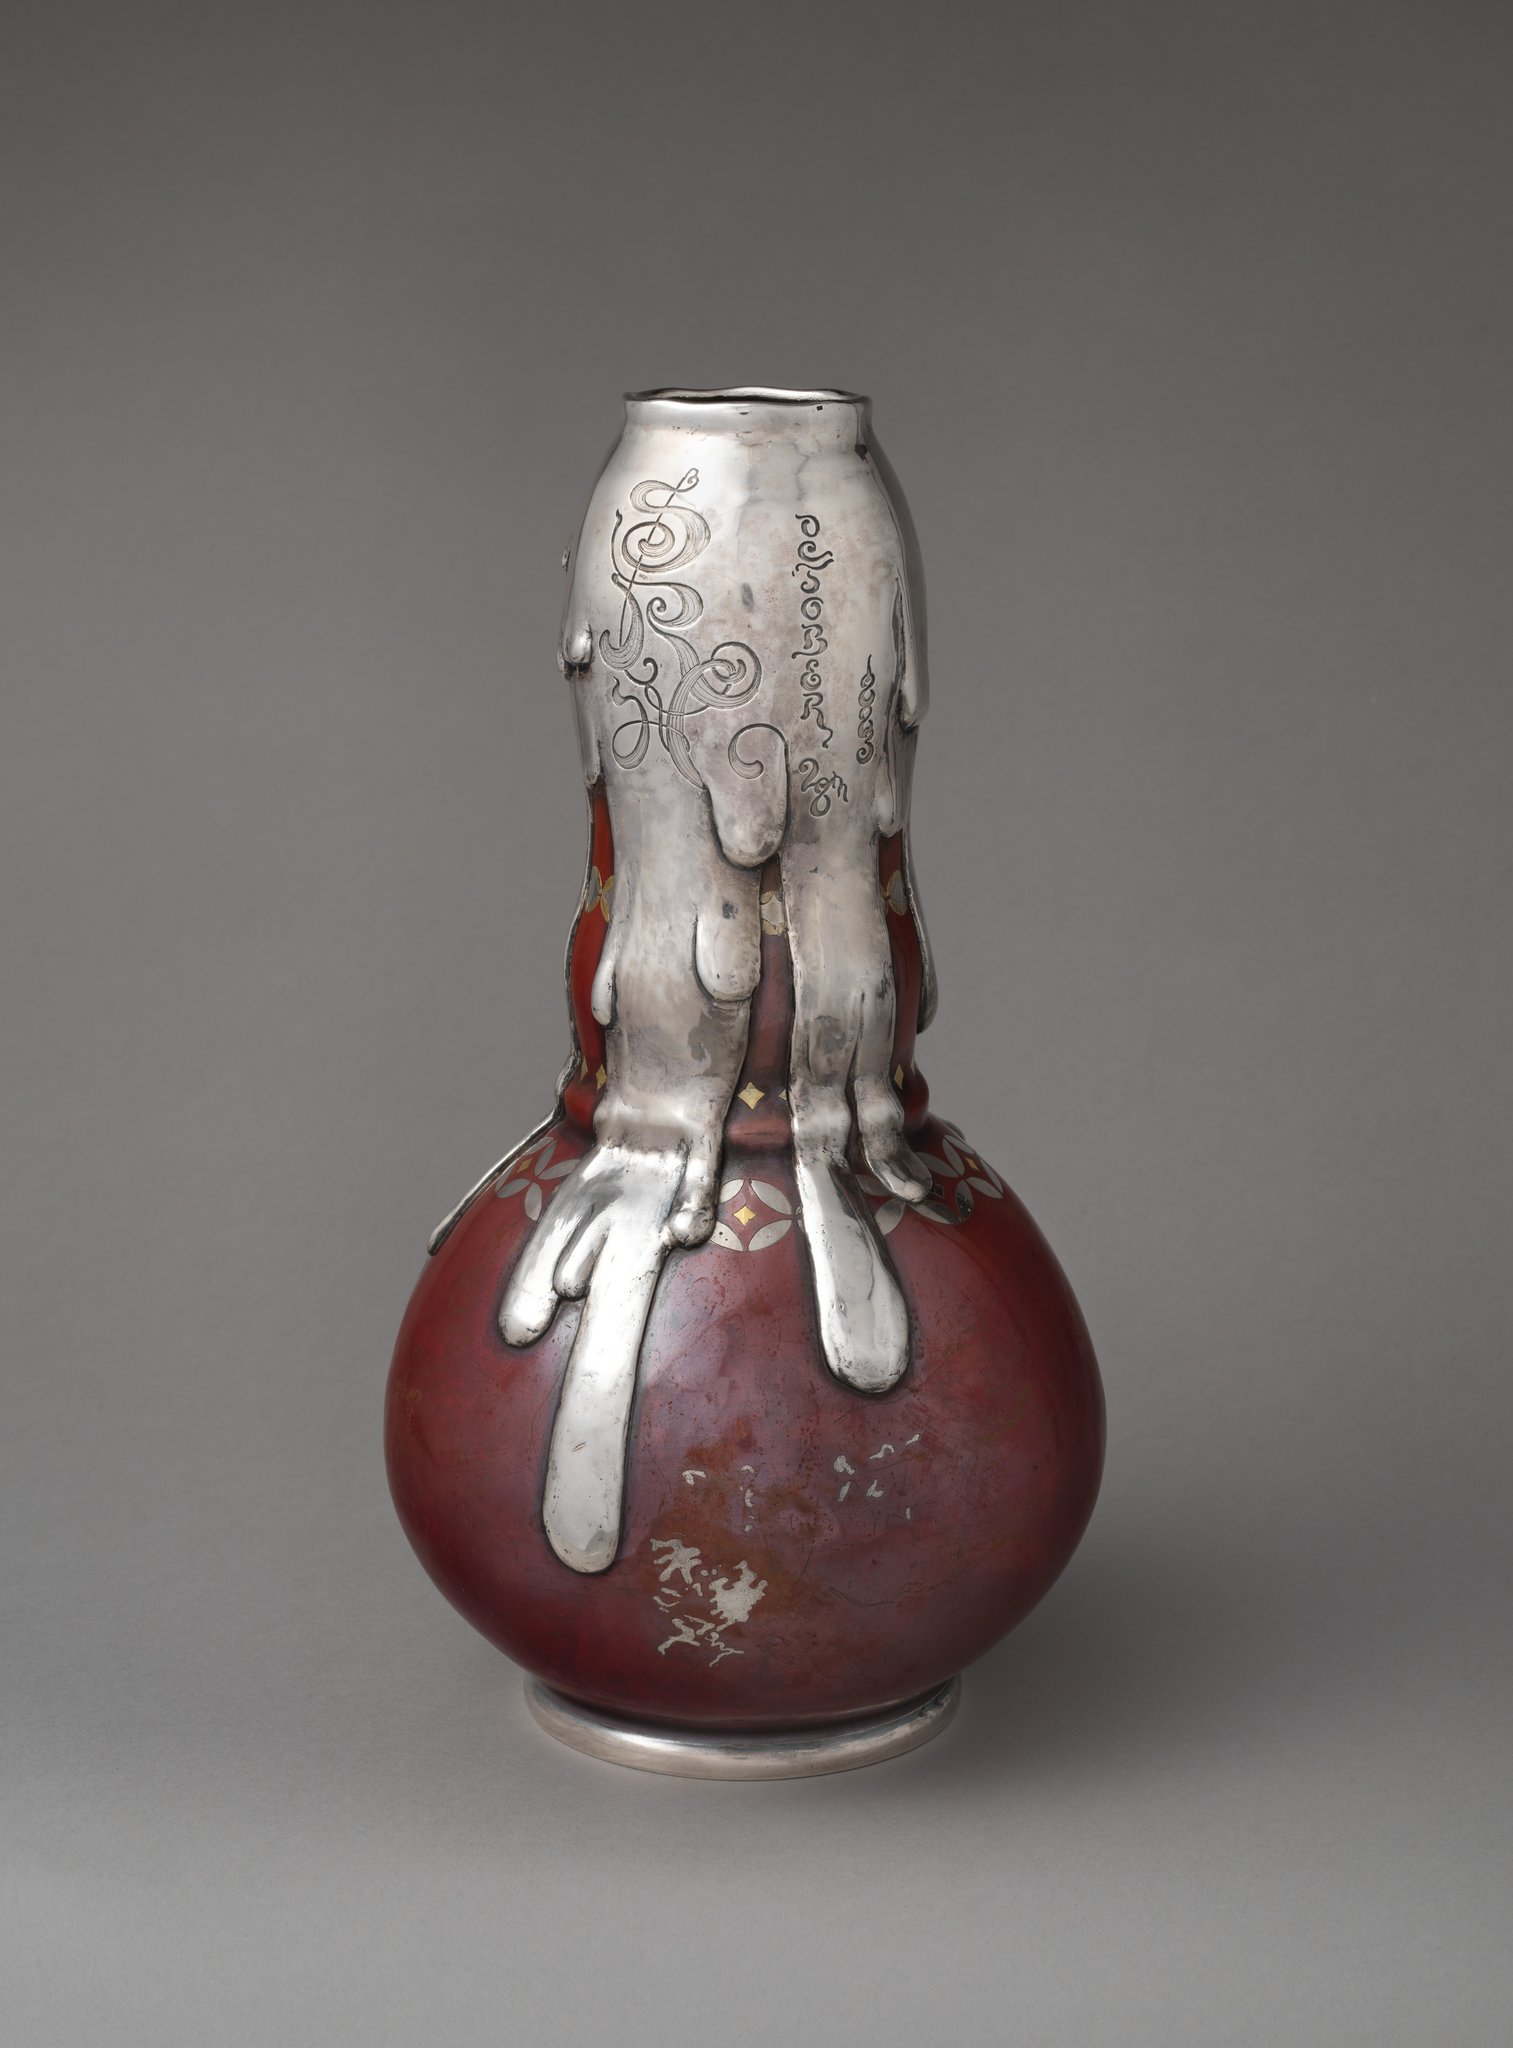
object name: vase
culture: american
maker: tiffany & co.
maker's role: maker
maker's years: 1837-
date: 1879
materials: alloy, copper, gold, silver, zinc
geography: united states